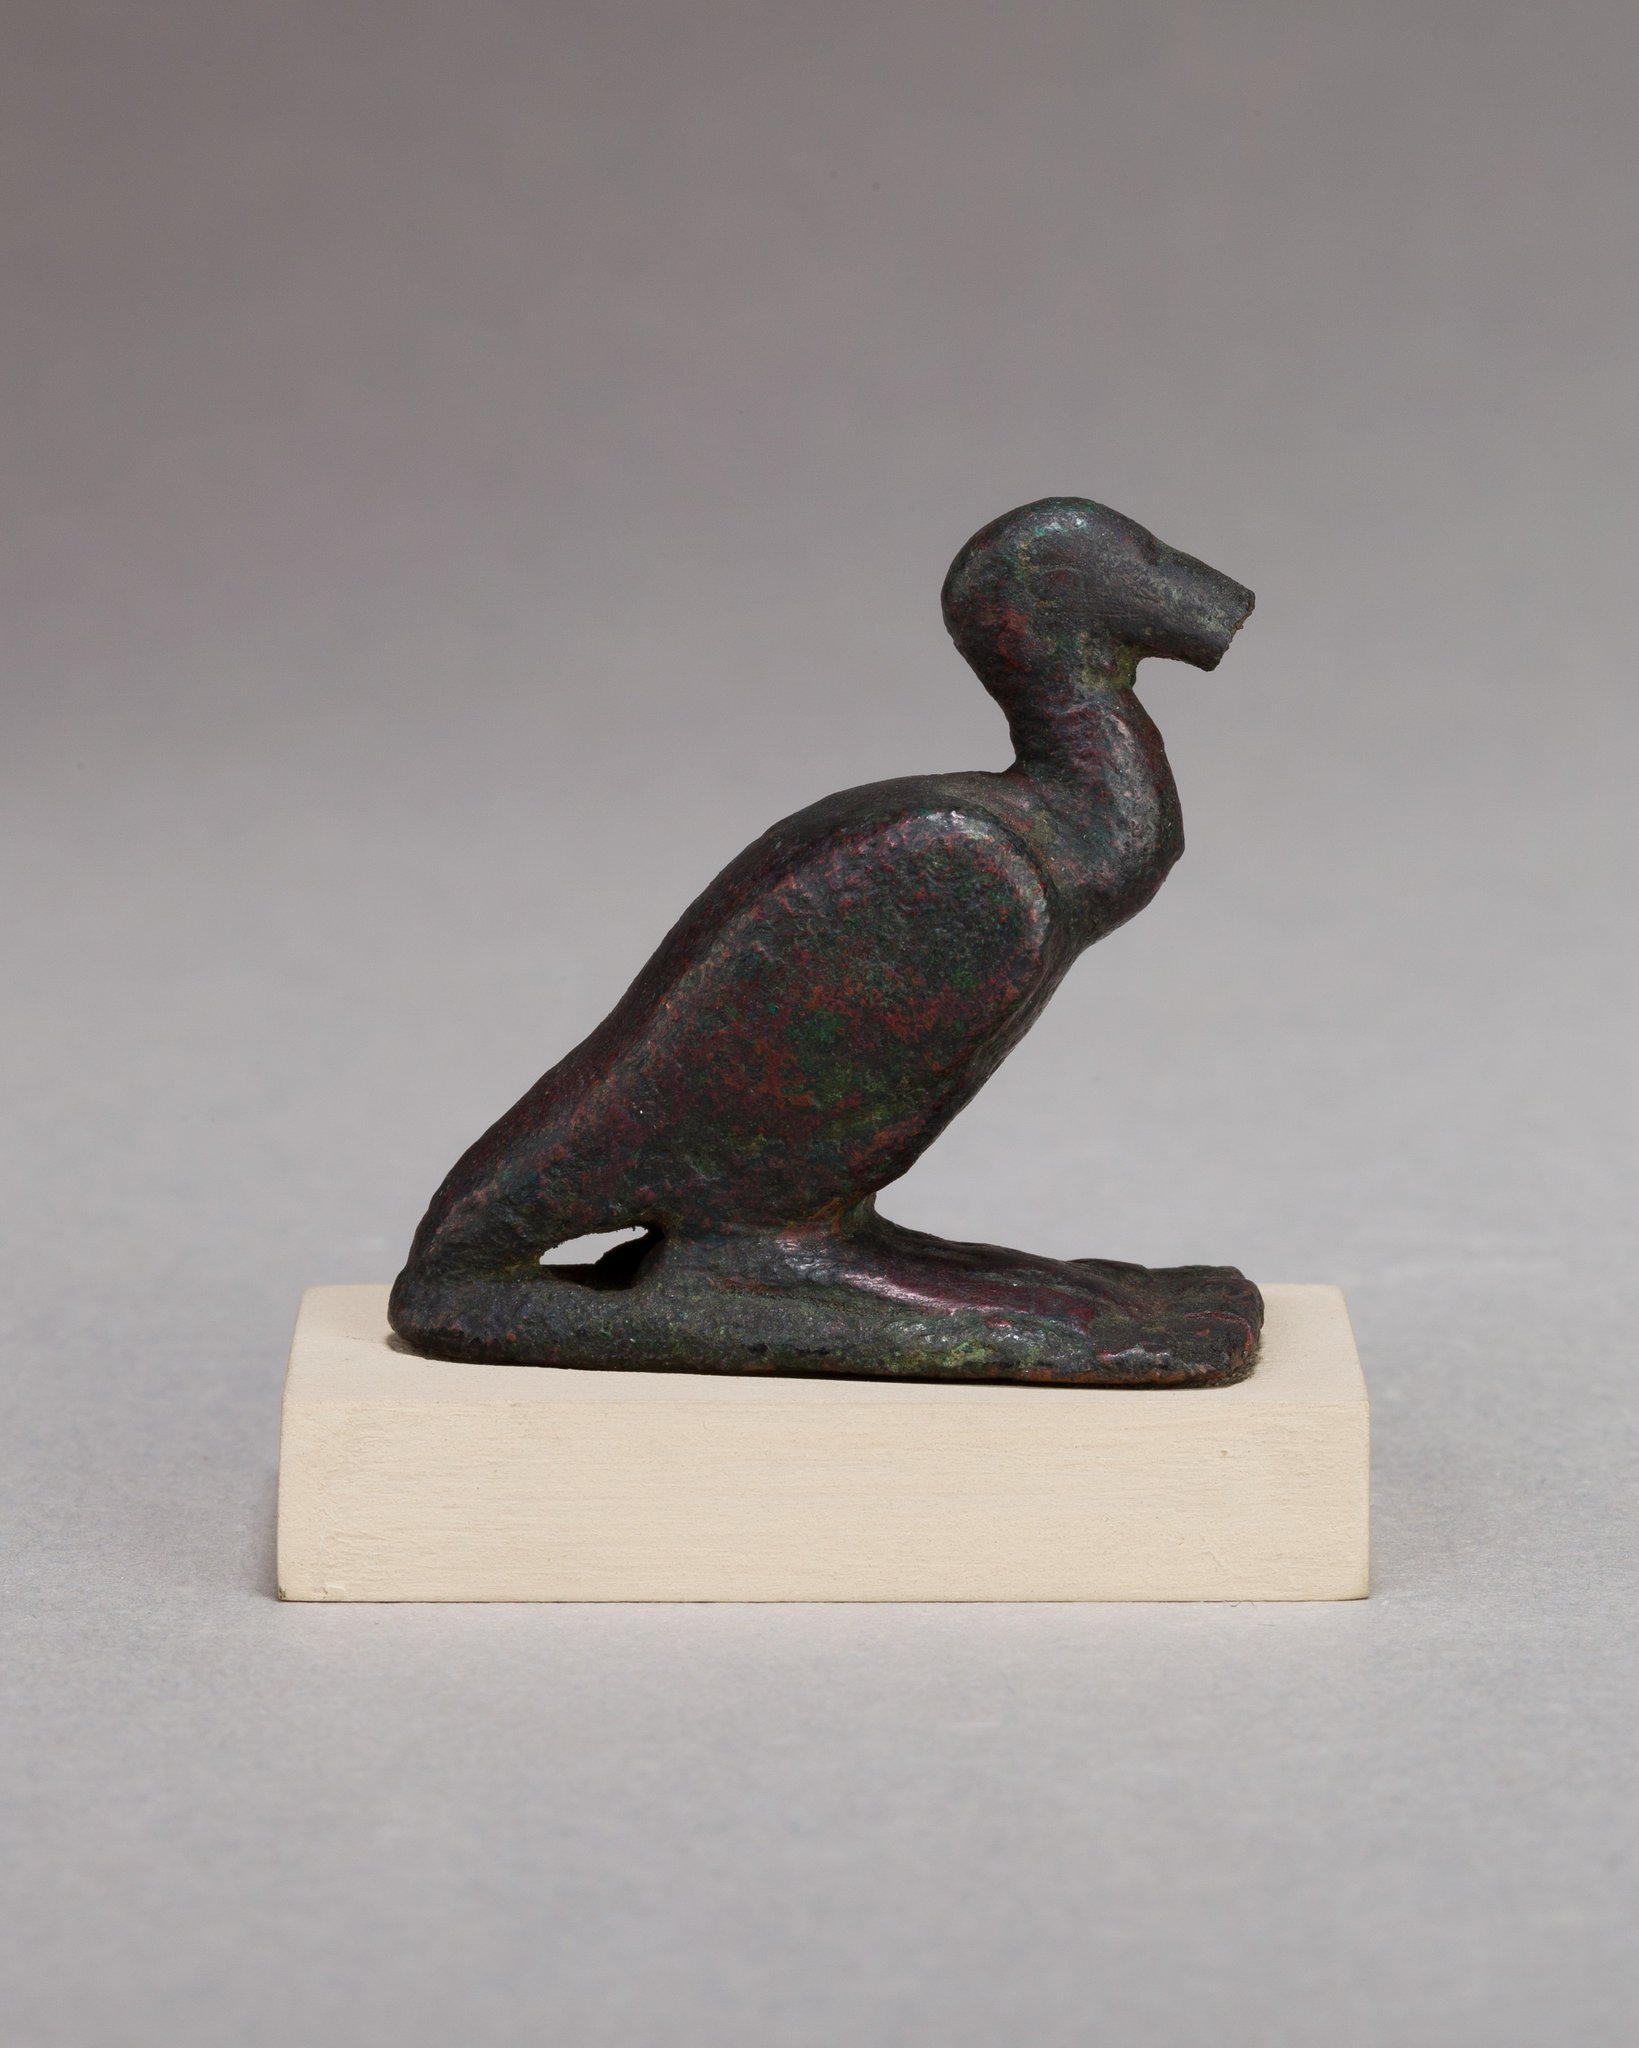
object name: figurine, ibis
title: Ibis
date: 664-630 BCE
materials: metal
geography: egypt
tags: birds